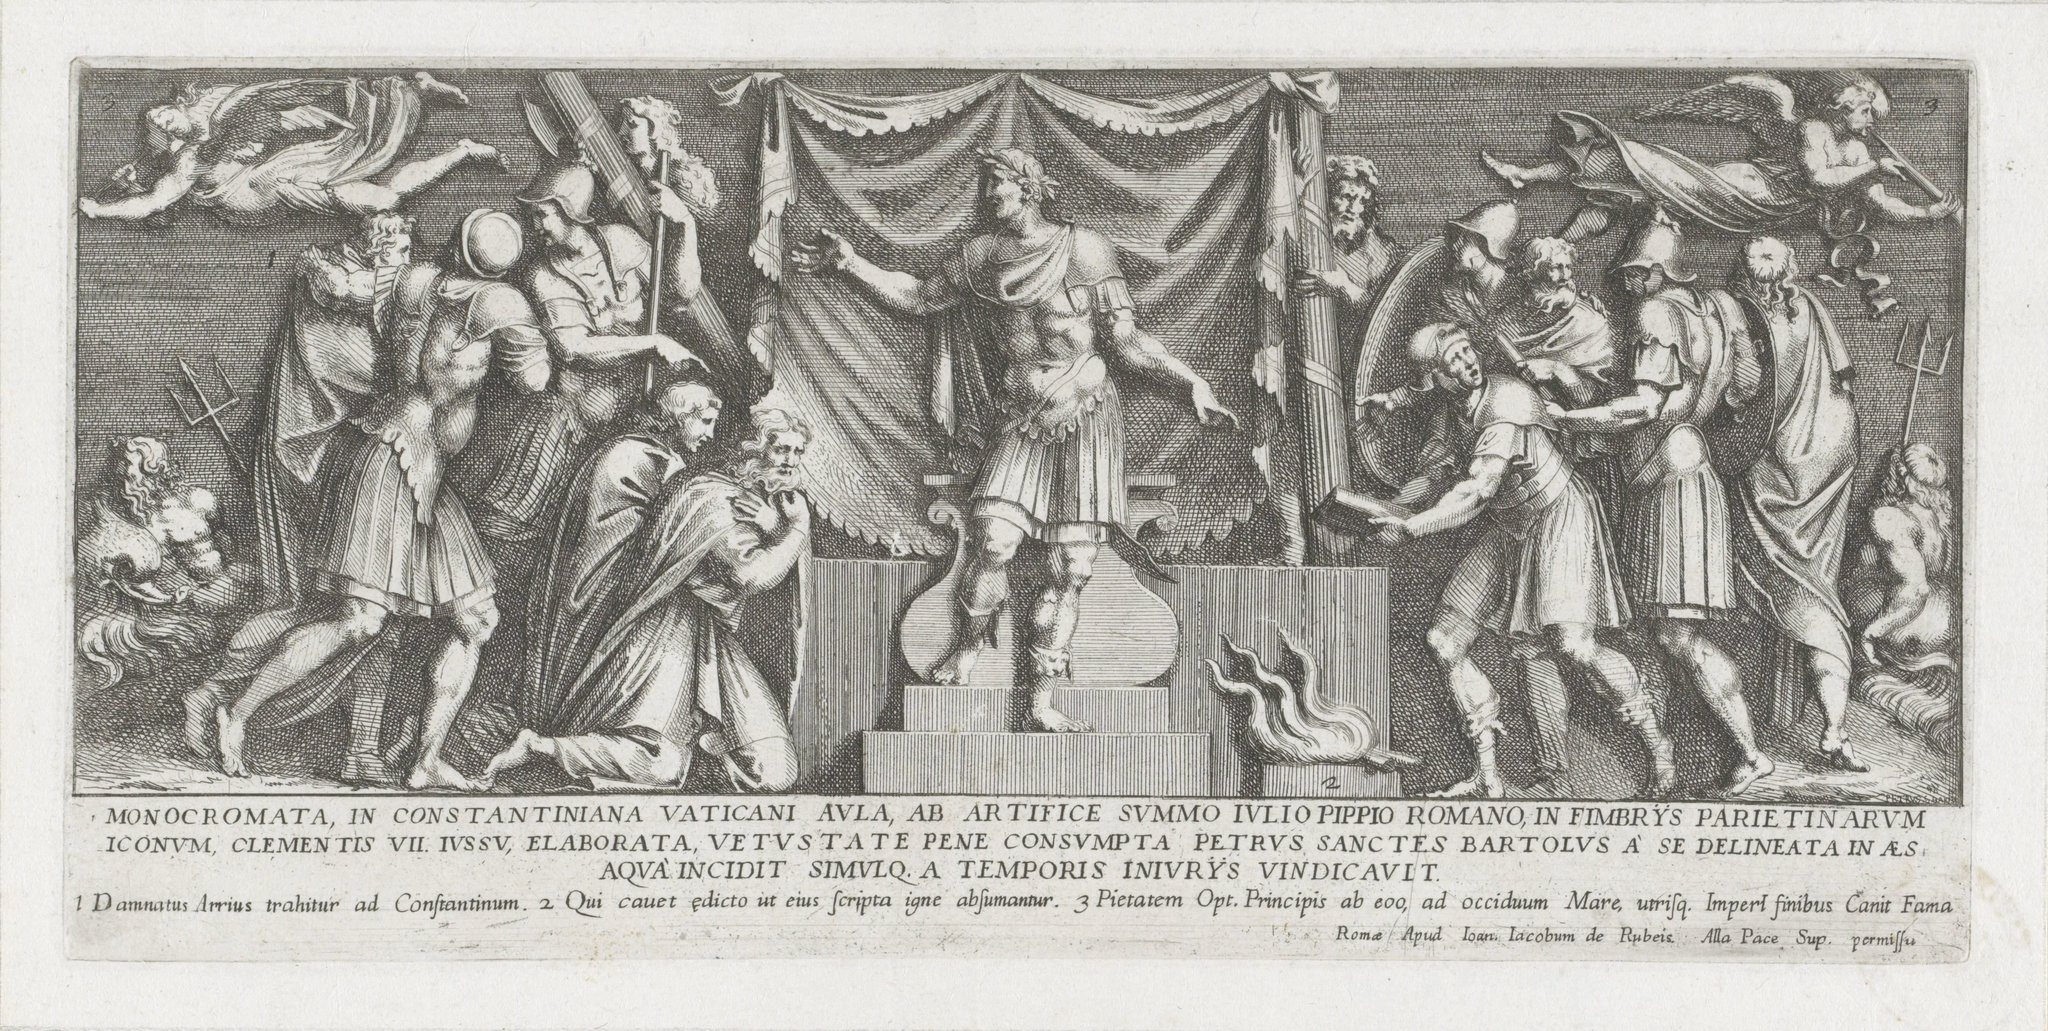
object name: print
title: Geschiedenis van keizer Constantijn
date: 1645-1700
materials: paper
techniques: engraving, etching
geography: rome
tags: the roman emperor constantine the great; possible attributes: crown, sceptre, standard (labarum) with chi-rho monogram or cross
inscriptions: collector's mark: Lugt 240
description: Keizer Constantijn staat voor een altaar. Naast hem staan soldaten. Linksvoor knielen twee mannen. Uiterst links en rechts liggen twee riviergoden. Titel en legenda in de ondermarge.